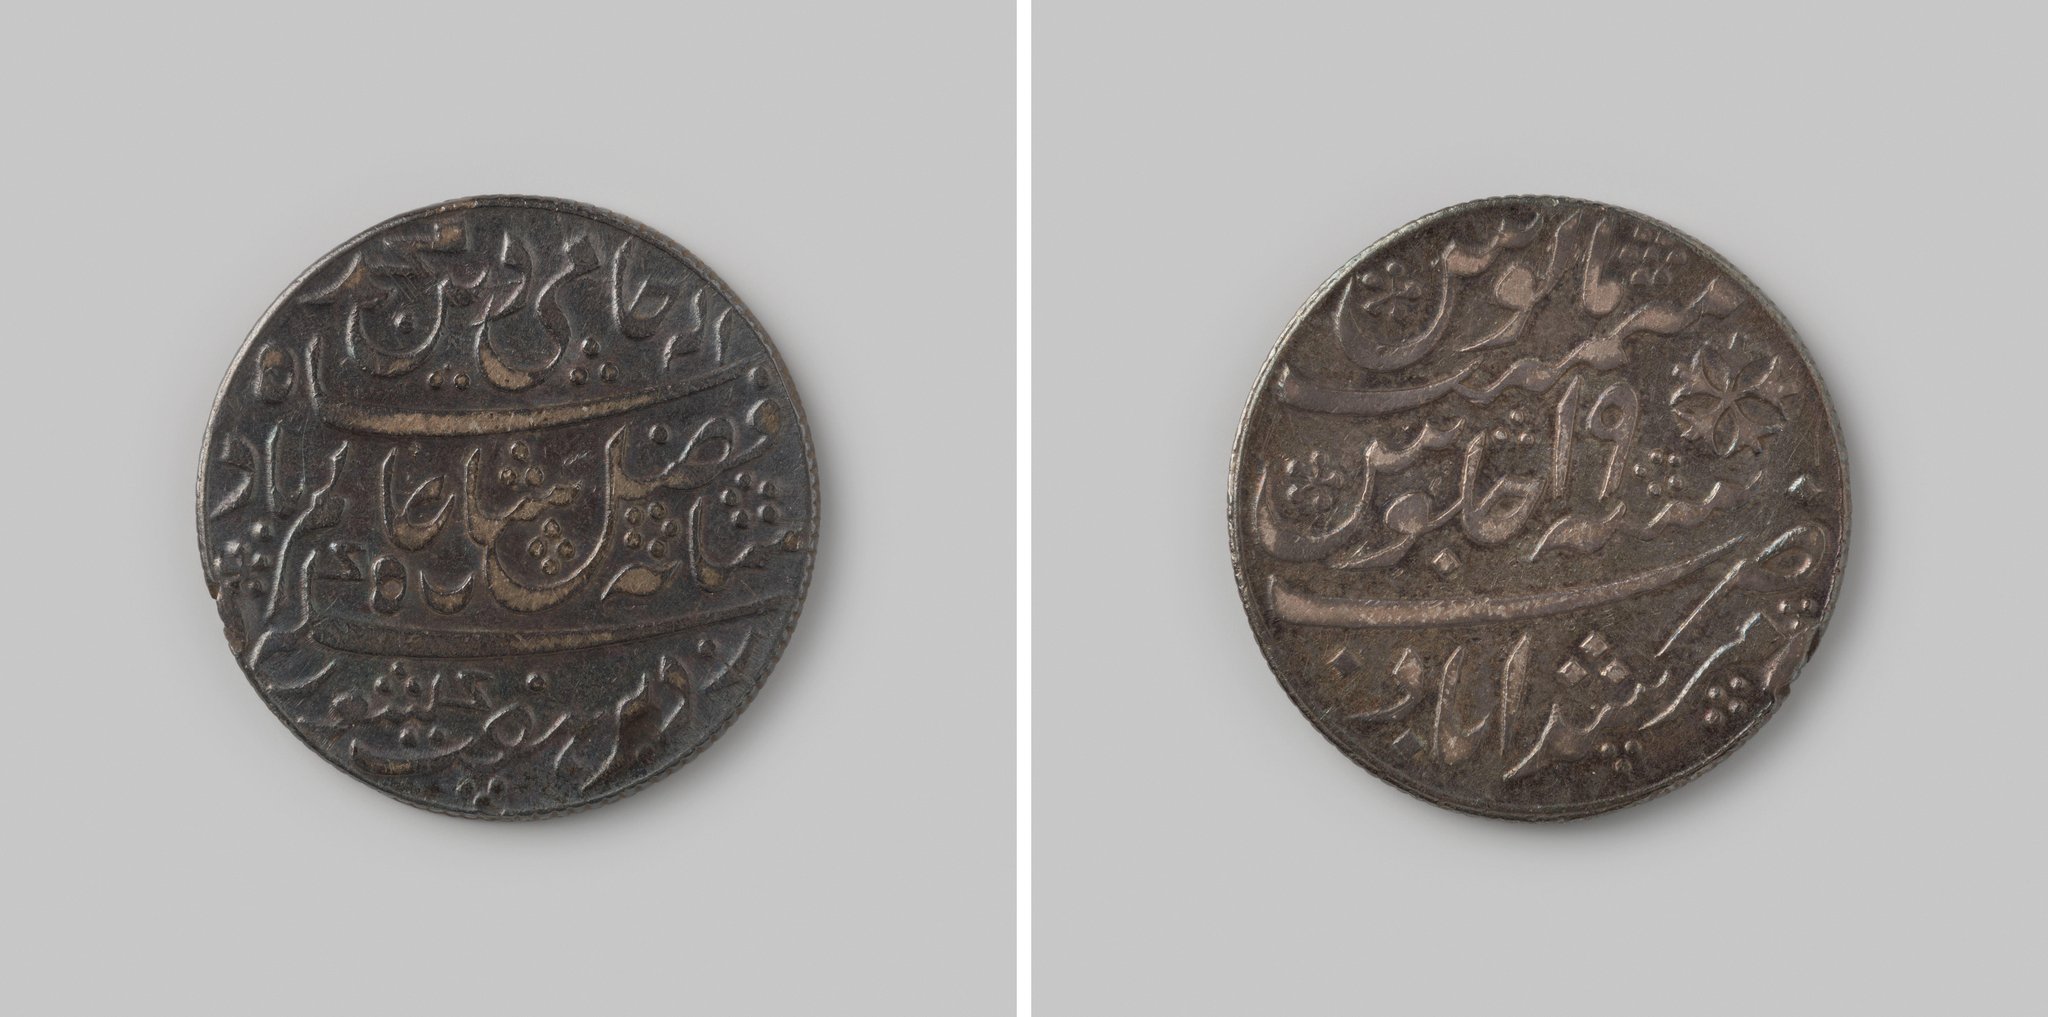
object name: coin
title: Roepie uit Bengalen in India van de Engelse Oostindische Compagnie (EIC) op naam van Sjah Alam I met regeringsjaar 19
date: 1777-1830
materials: silver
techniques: striking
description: Zilveren munt. Voorzijde: in Arabische lettertekens in drie regels opschrift. Keerzijde: in Arabische lettertekens in drie regels opschrift. Boven tweede regel aanduiding van het "eeuwige" regeringsjaar: 19. Kartelrand.